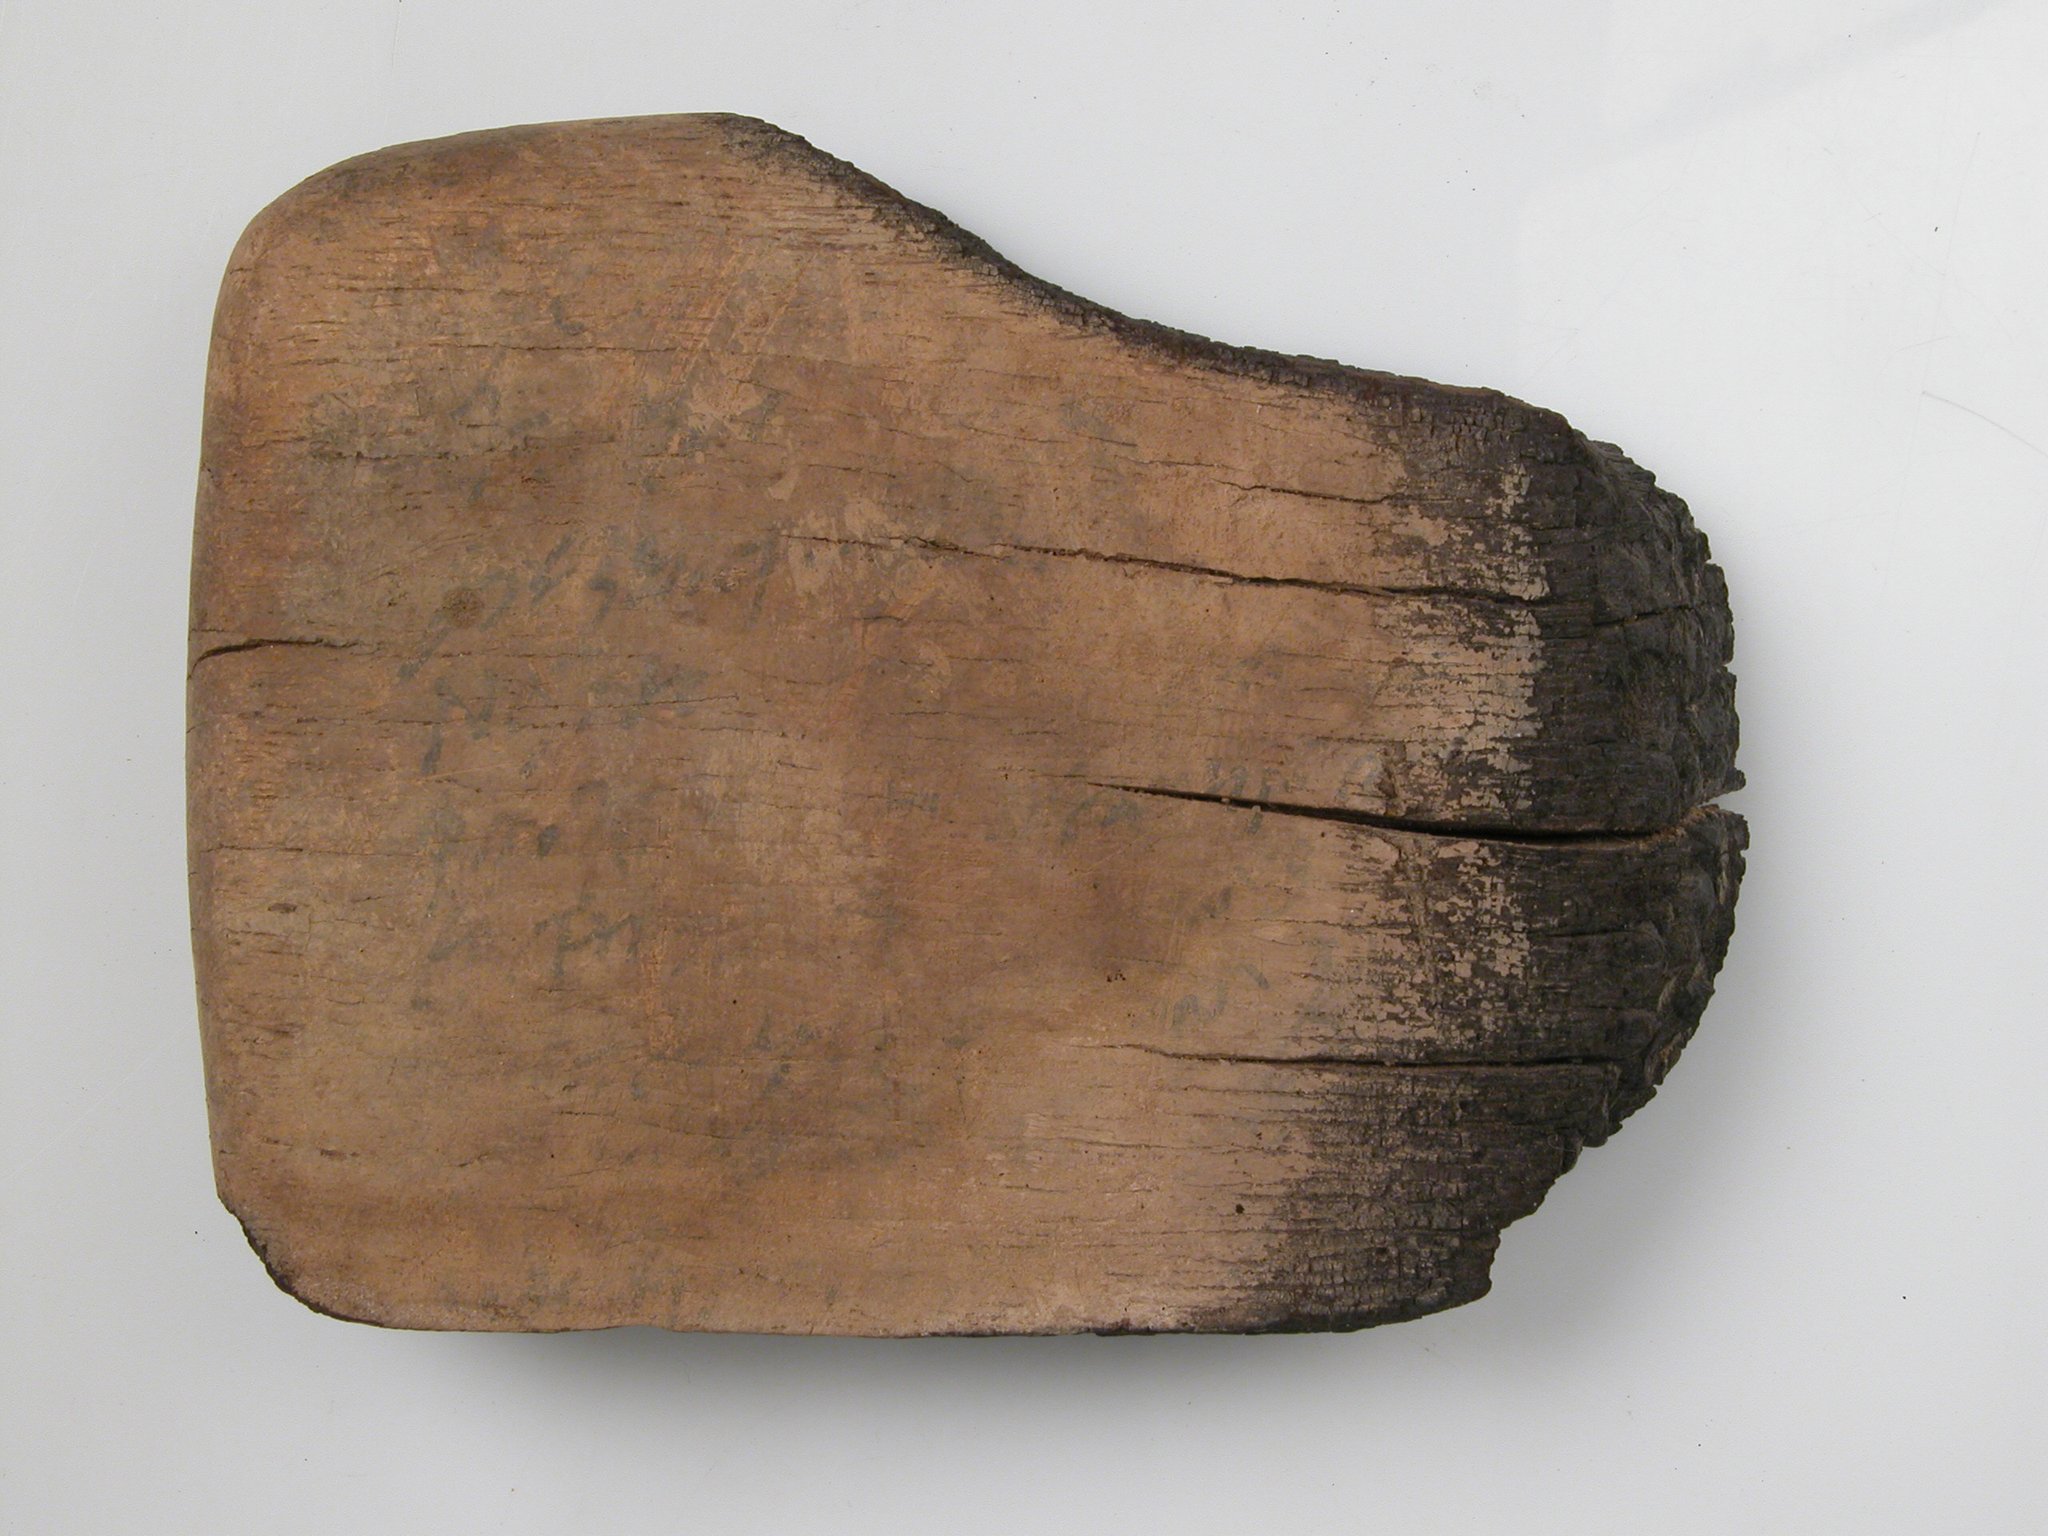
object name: plaque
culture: coptic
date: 301-700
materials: wood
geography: egypt